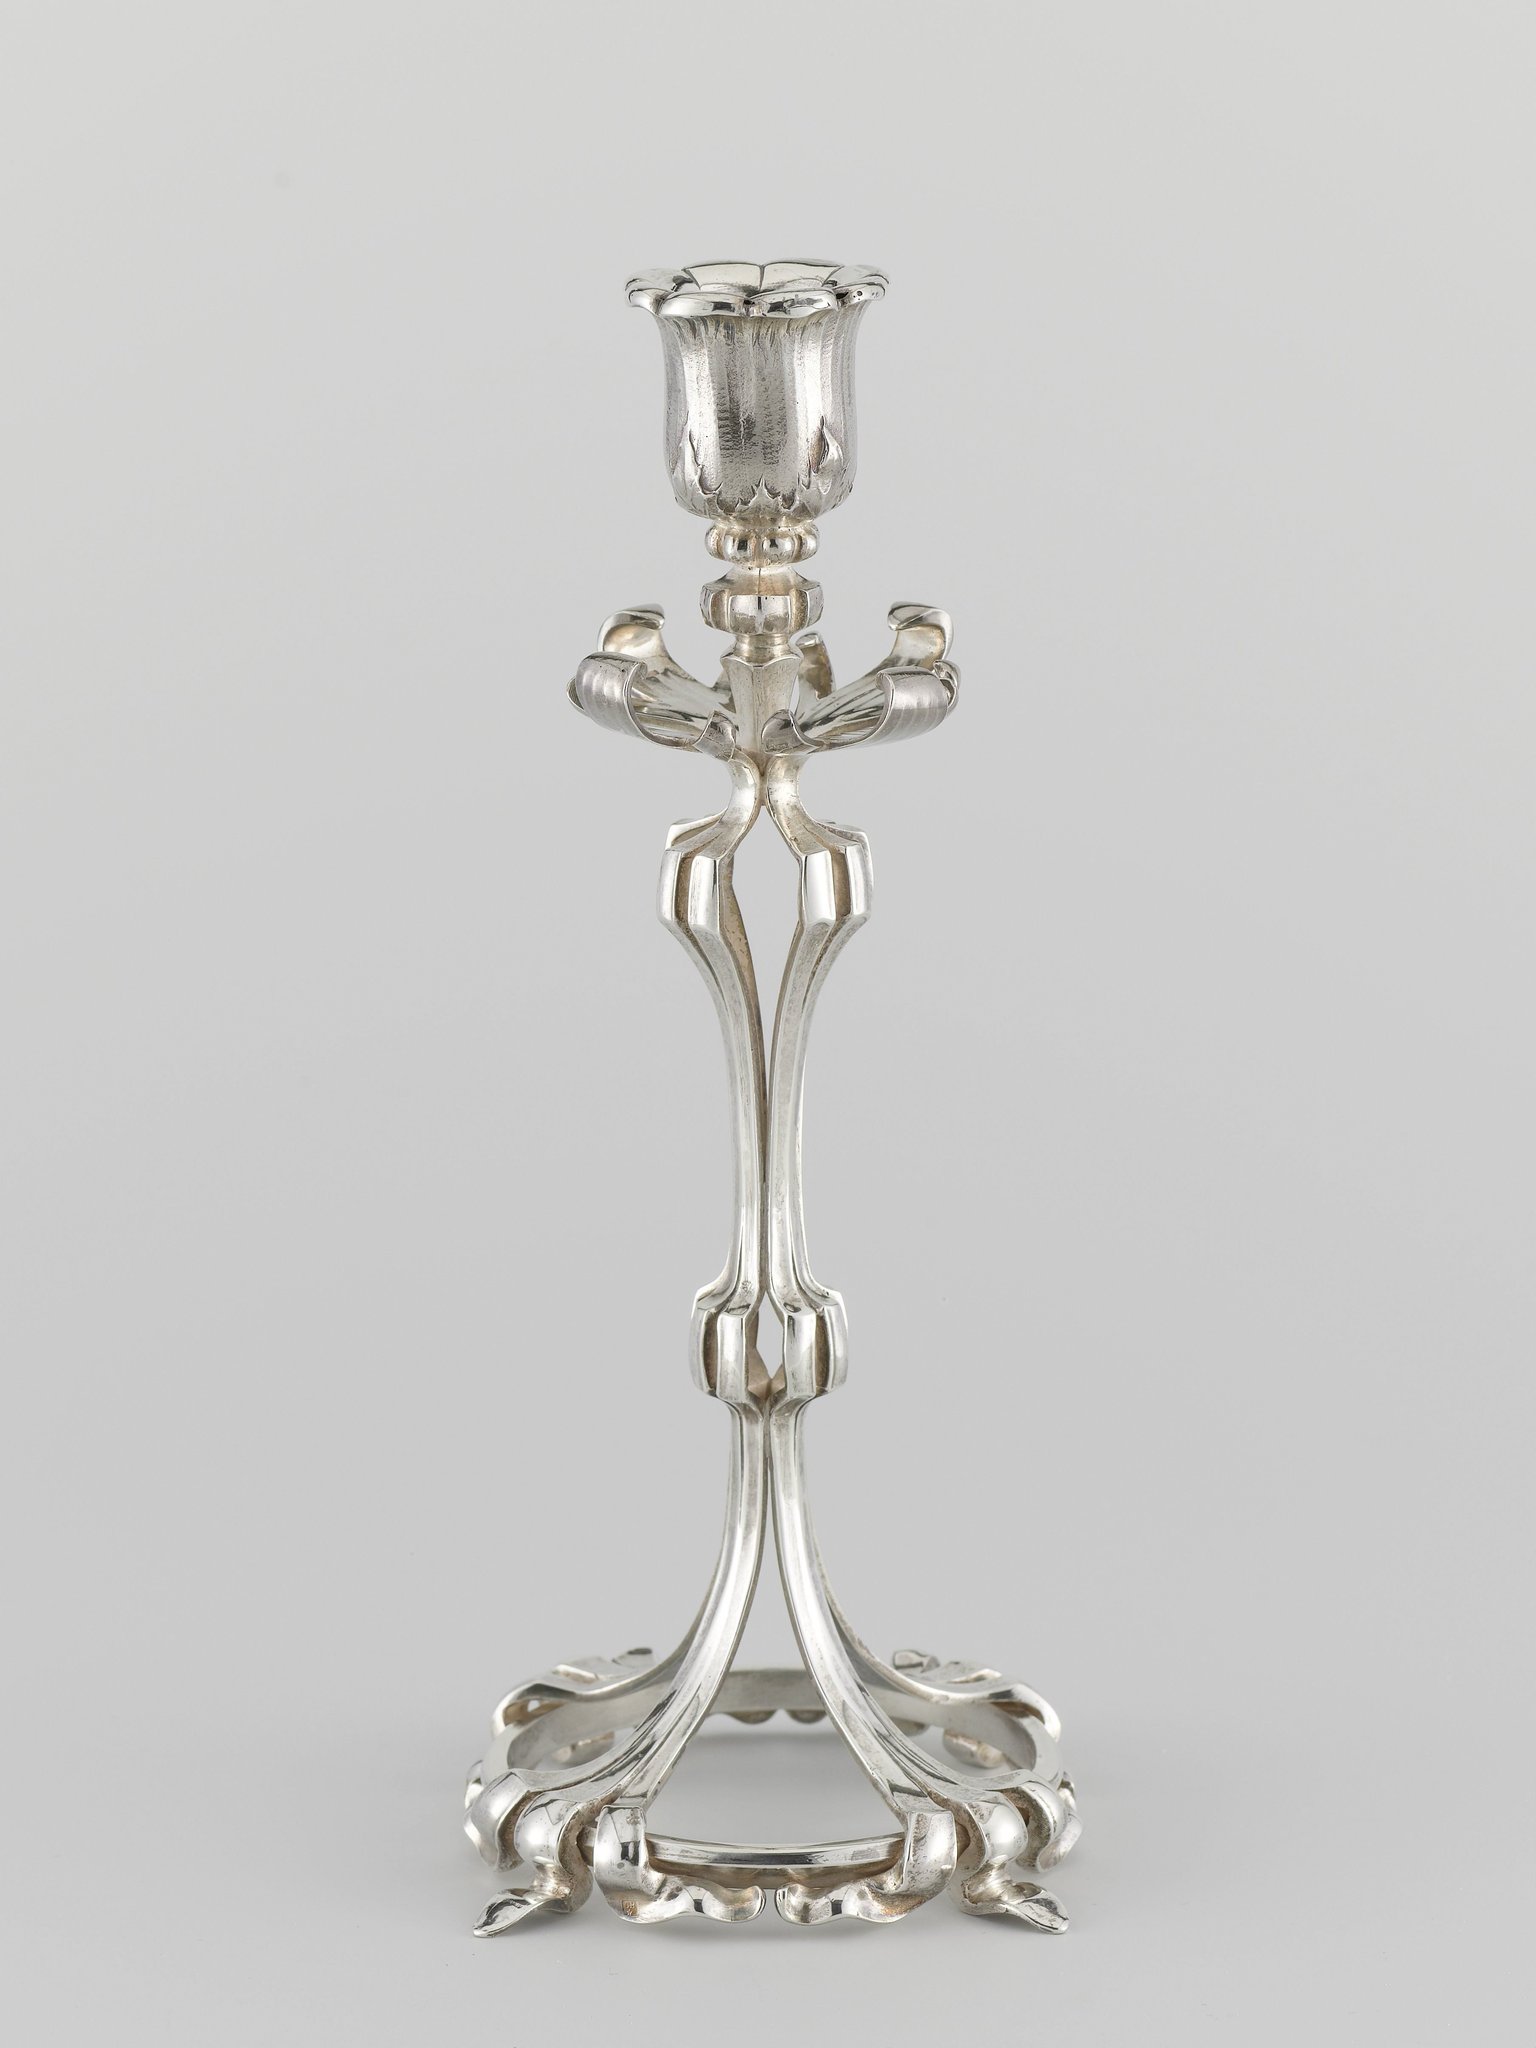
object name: candlestick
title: Kandelaar, opgebouwd uit ranken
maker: a.f. gips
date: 1904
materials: silver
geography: utrecht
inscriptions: signature and date: ‘minervakop; leeuw 1ste gehalte; jaarletter K (1904); mt CB waaronder vijfster; essaieursteken HA aaneen met 1 in rechthoek = R.L. Hora Adema, Utrecht’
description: Two candelabra. Silver. Utrecht, N.V. Koninklijke Utrechtse Fabriek van Zilverwerk C.J. Begeer, 1904, designed in 1900 by A.F. Gips. Acquired with support of the Belport- Familienstiftung, 1990.